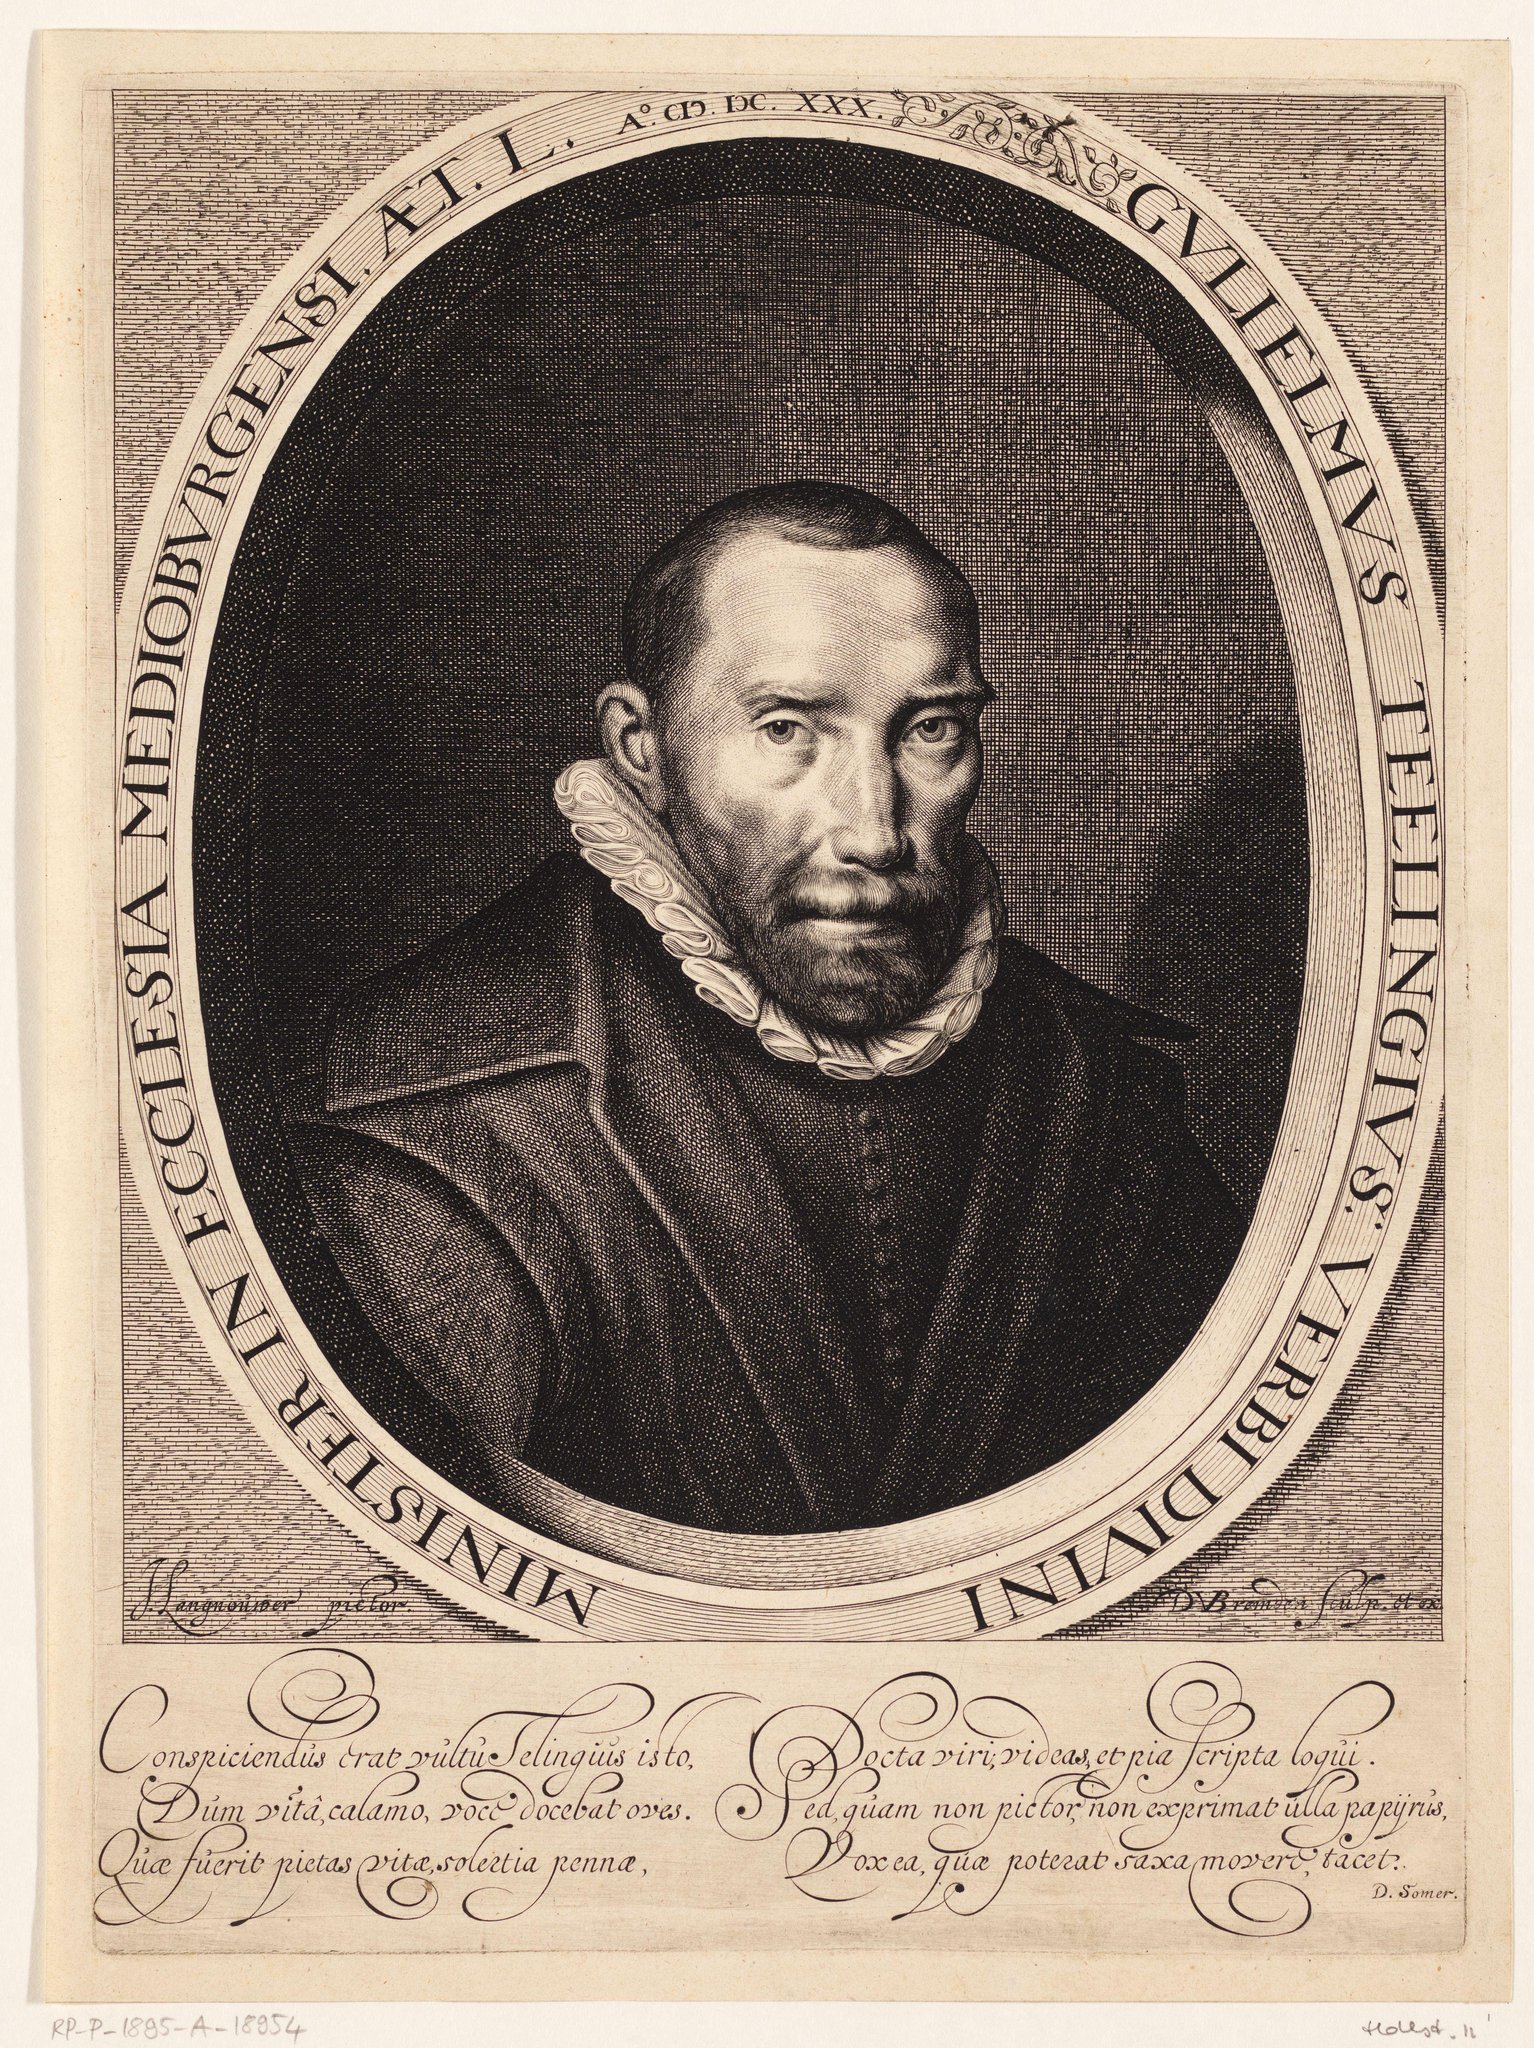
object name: print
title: Portret van Willem Teelinck op 50-jarige leeftijd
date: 1630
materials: paper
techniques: engraving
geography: amsterdam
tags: willem teellinck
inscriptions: collector's mark: Lugt 2228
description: Borstbeeld van de theoloog Willem Teelinck, in ovaal met randschrift. Onder het portret een Latijns vers van D. Somer.